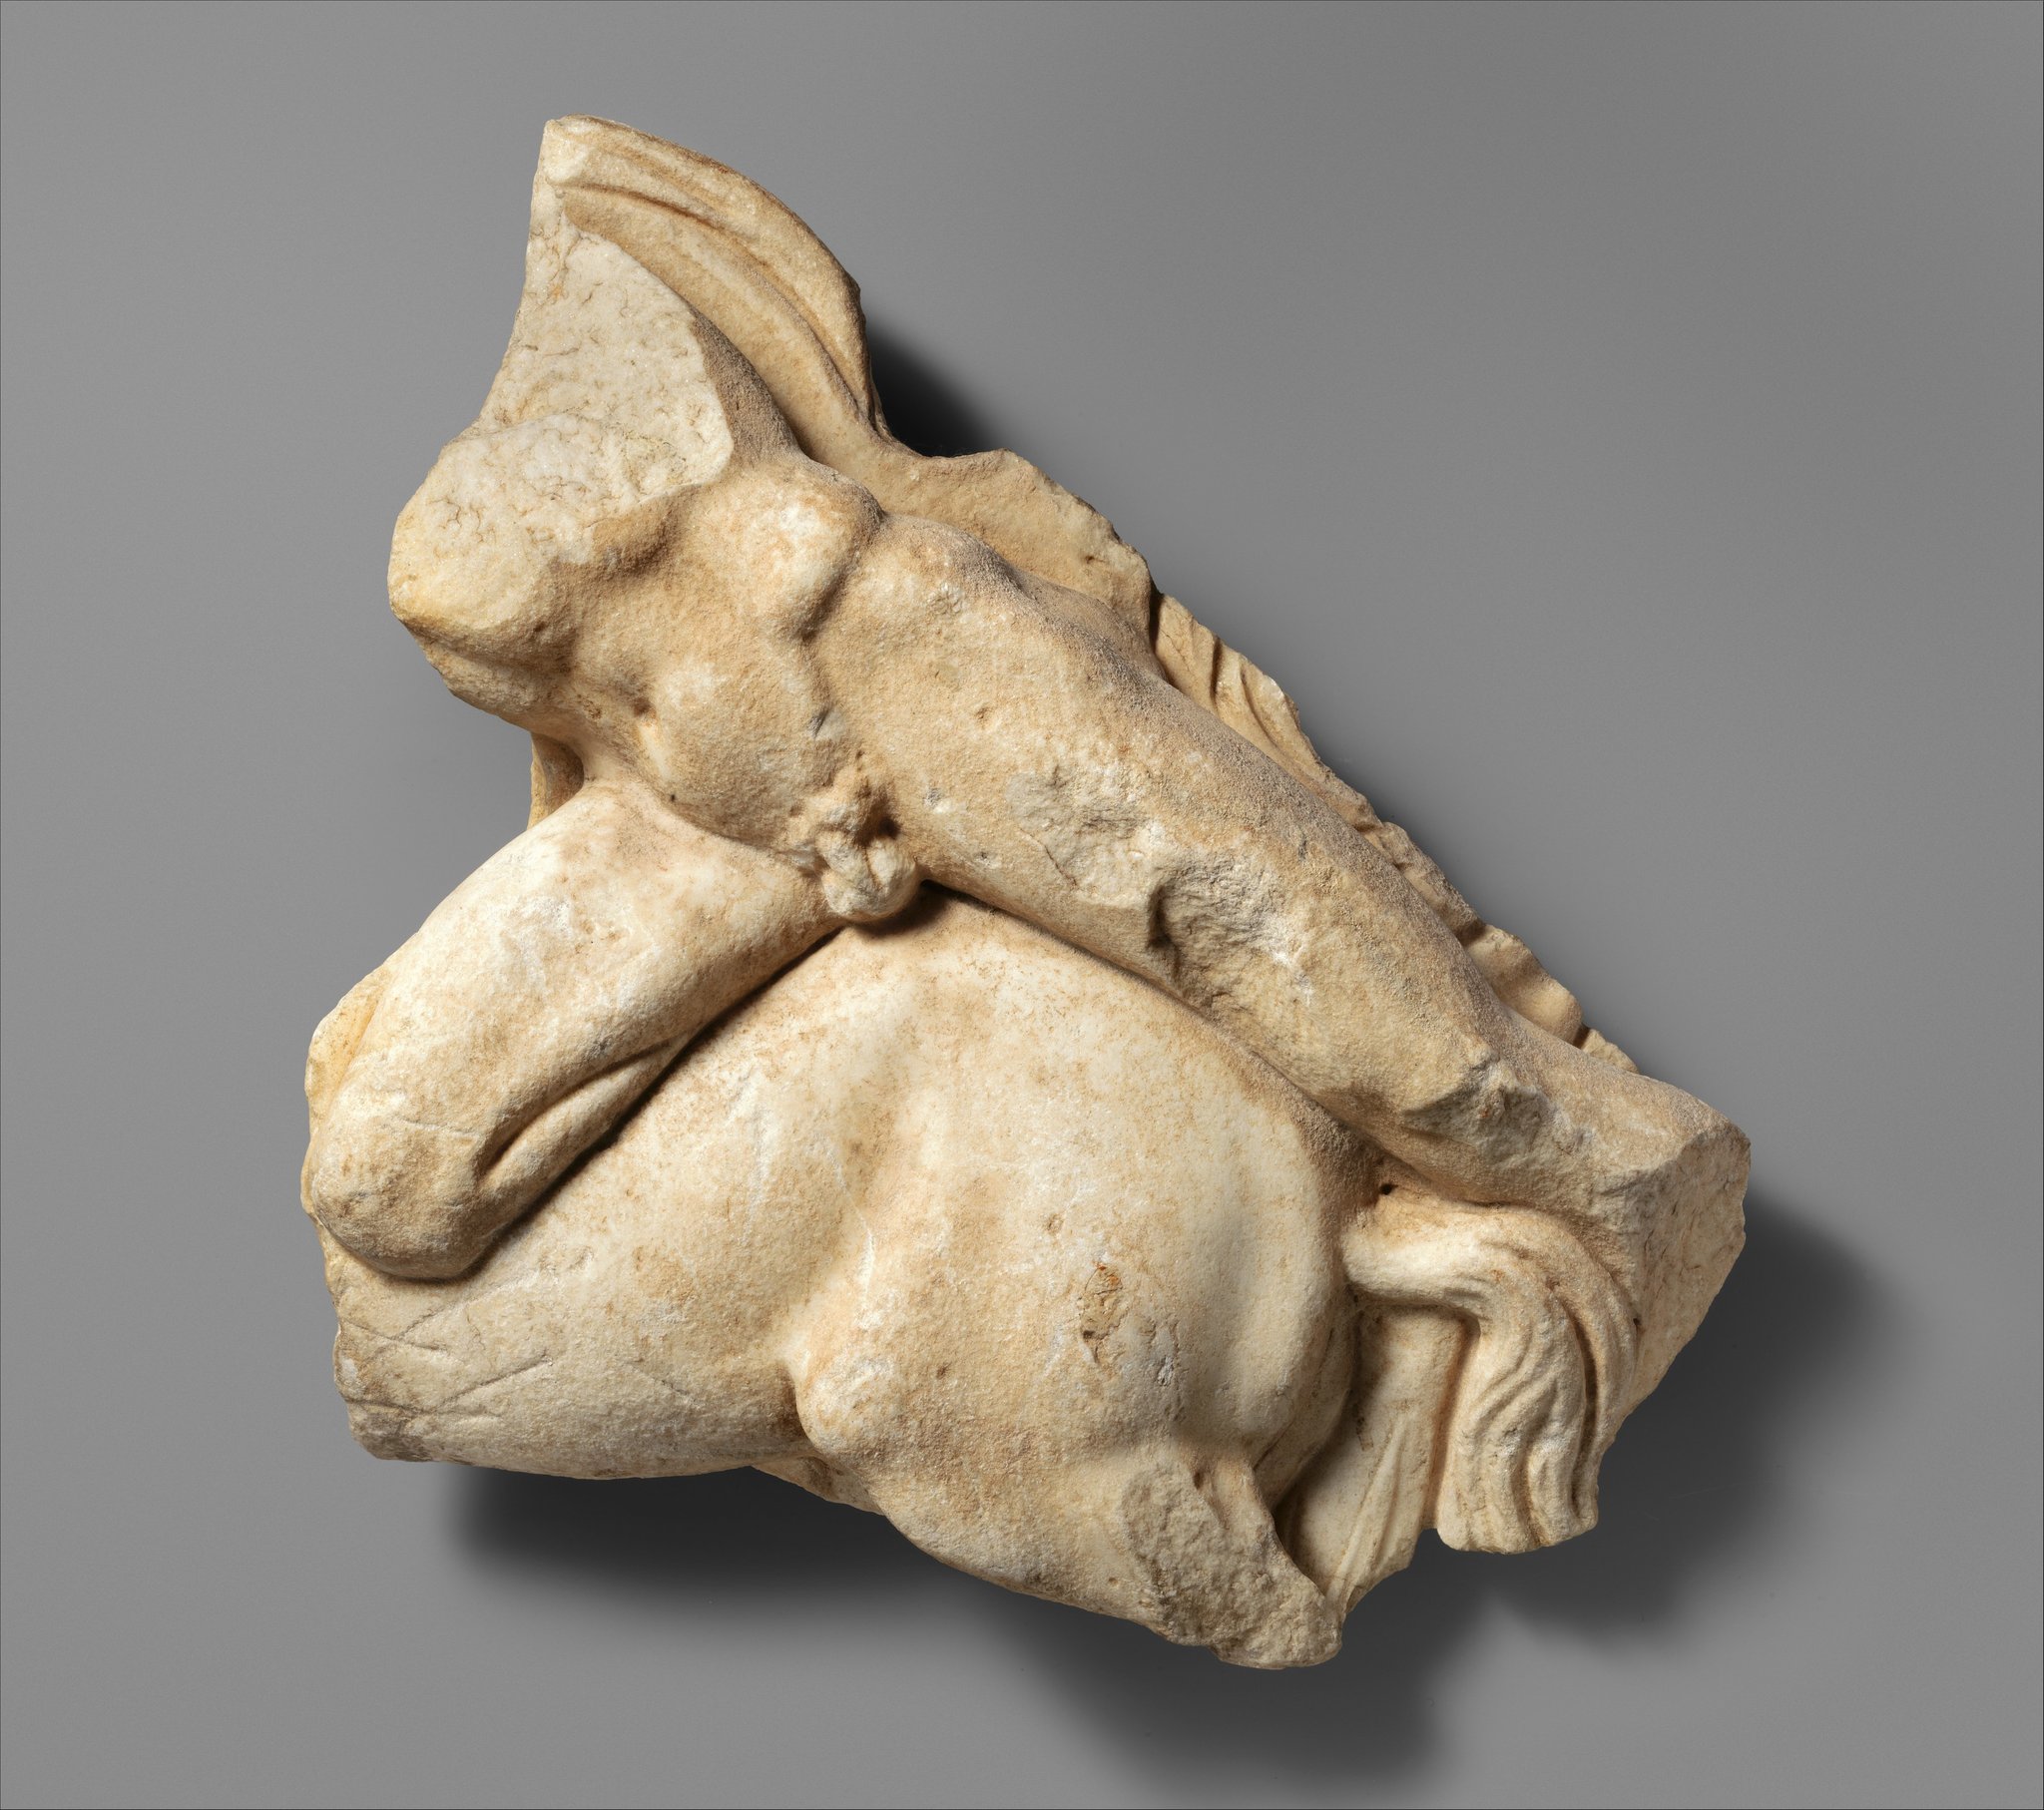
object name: relief fragment with a youth and horse or centaur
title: Marble relief fragment with centaur and Lapith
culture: greek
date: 300-101 BCE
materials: marble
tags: male nudes,centaurs